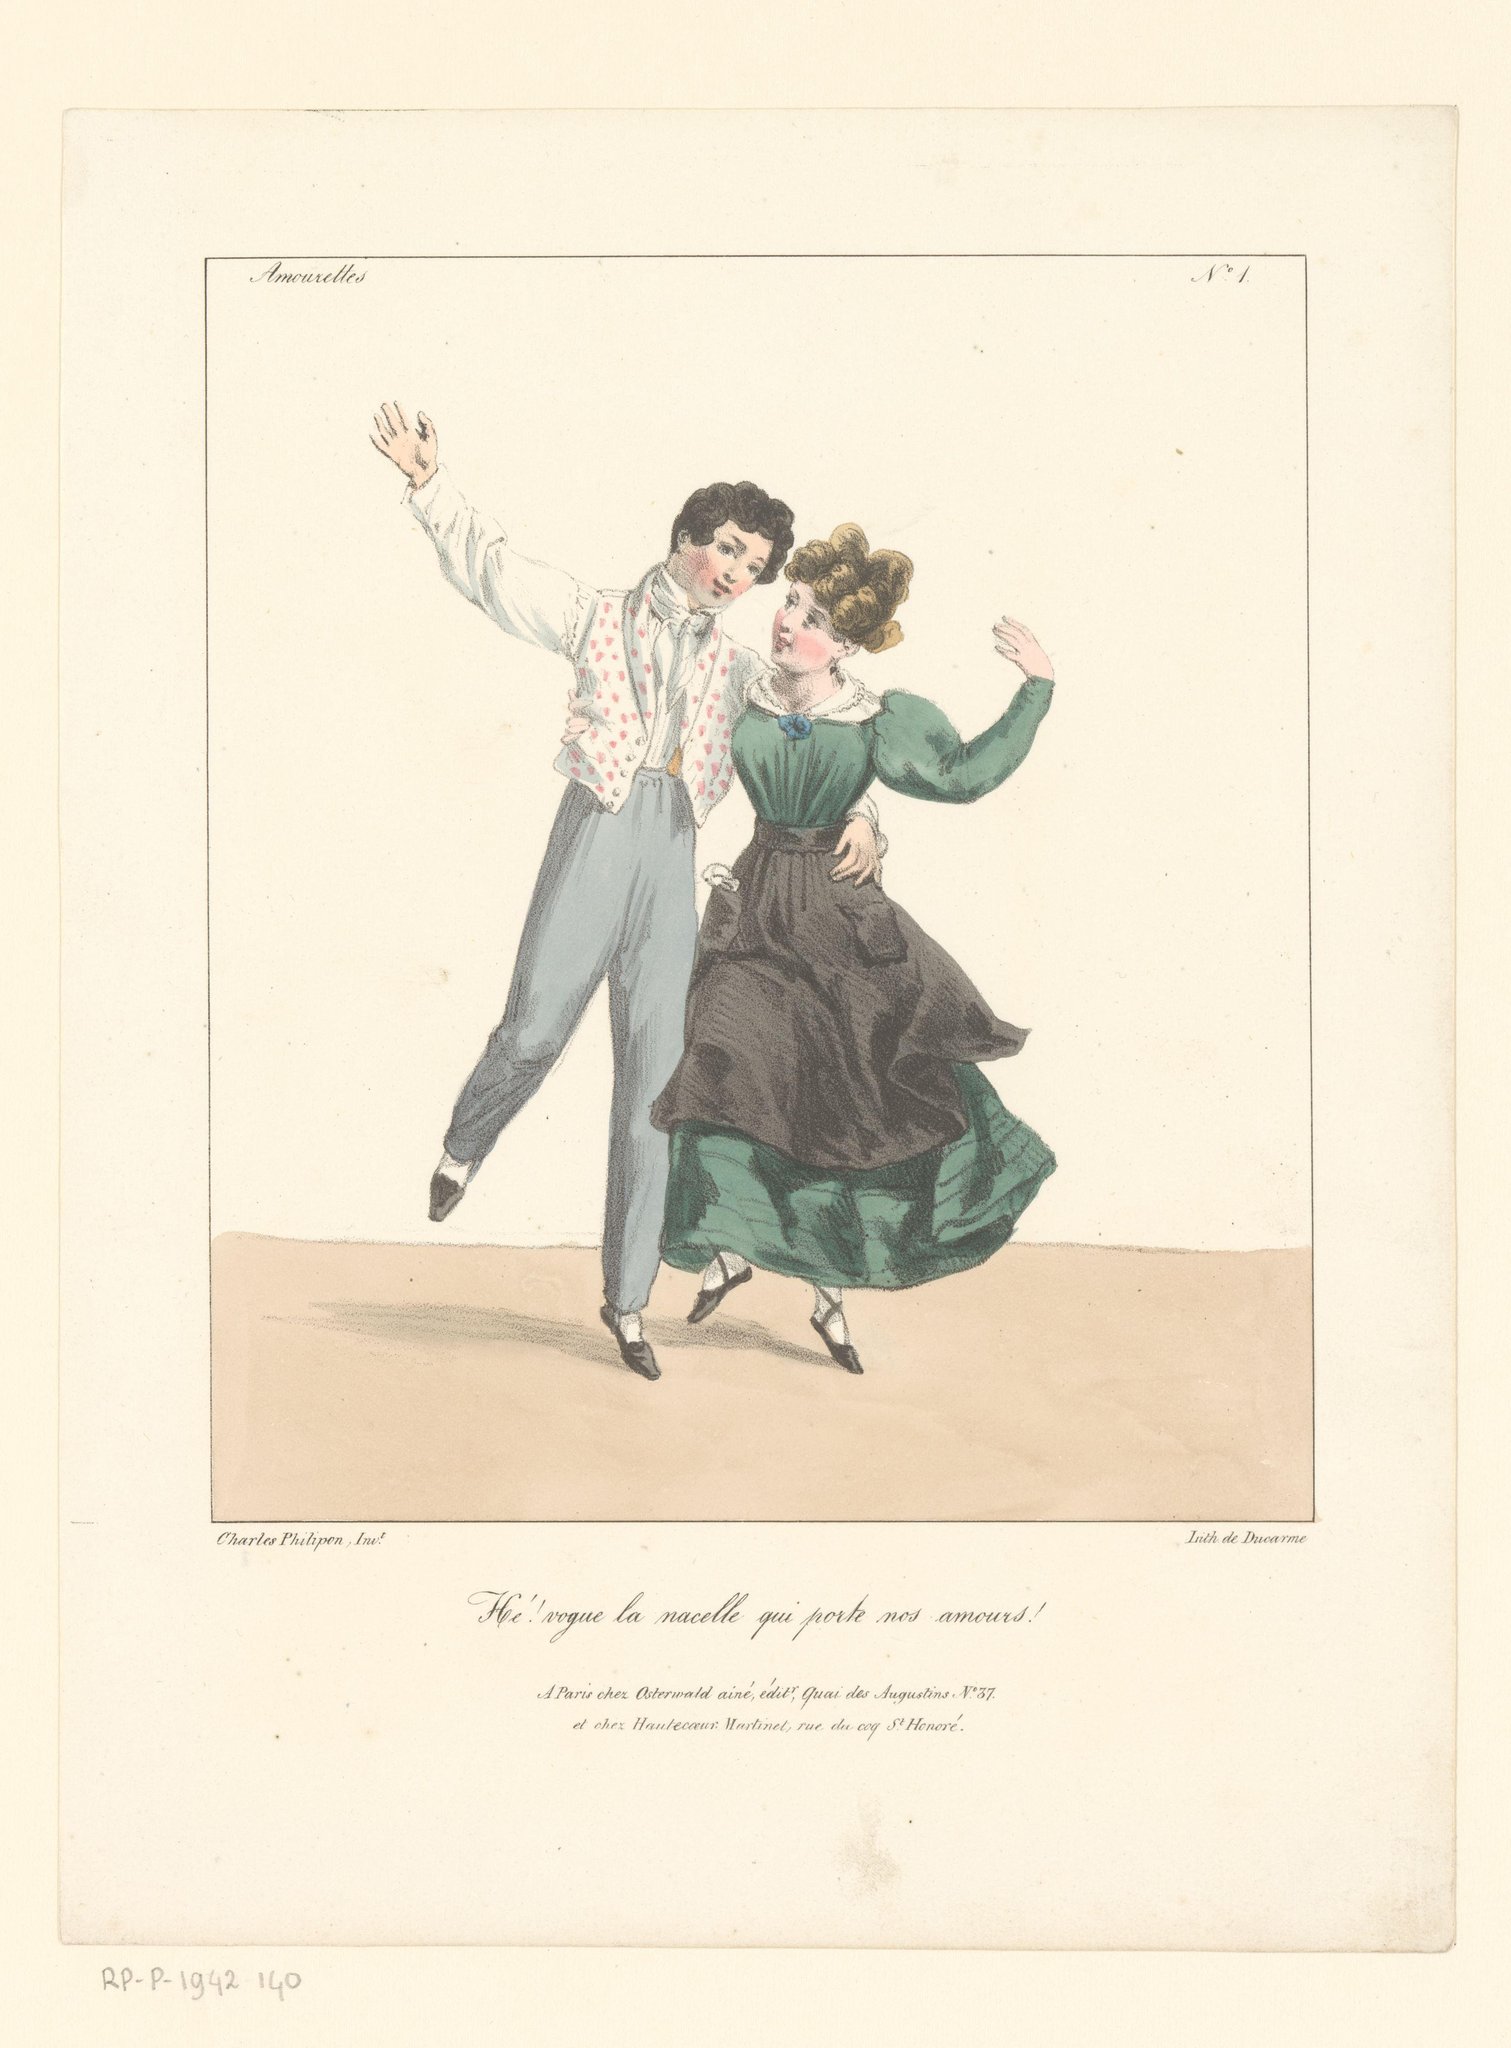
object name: print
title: Liefdestaferelen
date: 1827-1829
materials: paper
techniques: hand coloring, lithograph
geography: paris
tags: dancing, clothes, costume (+ women's clothes), clothes, costume (+ men's clothes), couple of lovers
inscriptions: collector's mark: Lugt 2228, collector's mark: Lugt 2760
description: Serie bestond in eerste instantie uit achttien prenten maar is later uitgebreid, onduidelijk naar hoeveel prenten precies.